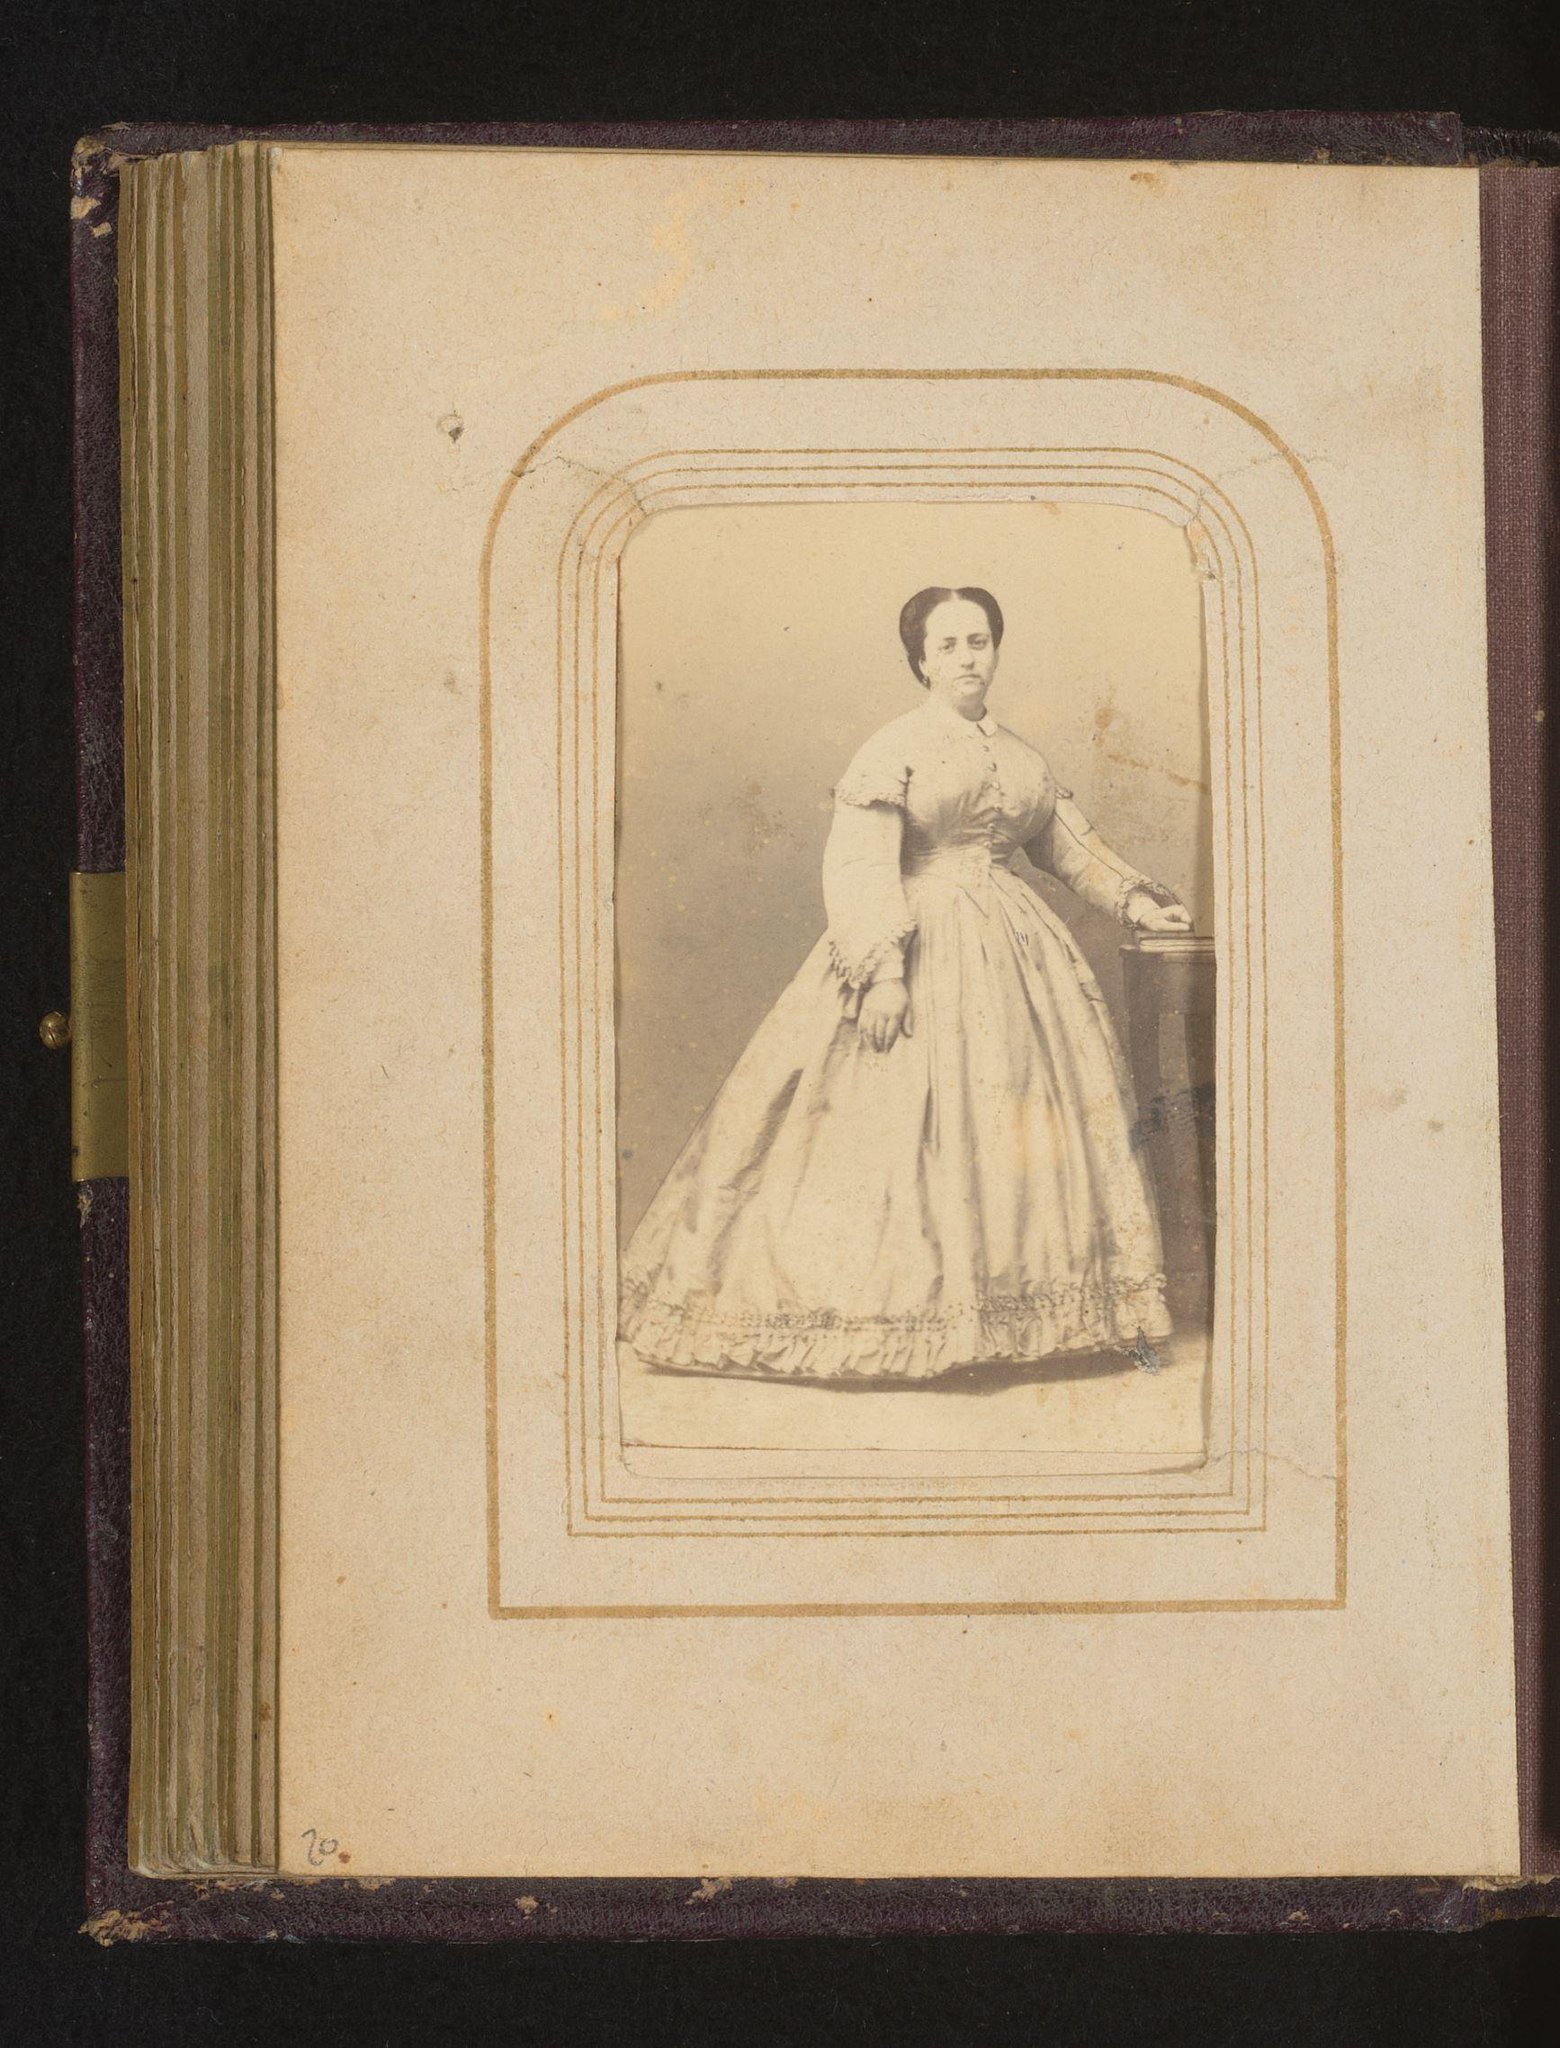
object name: album leaf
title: Portret van een staande vrouw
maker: Anonymous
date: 1860-1900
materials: cardboard, photographic support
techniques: albumen print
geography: madrid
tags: historical persons - bb - woman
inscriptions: inscription: ‘Fotografia/ Puerta del Sol [...]/ Madrid’